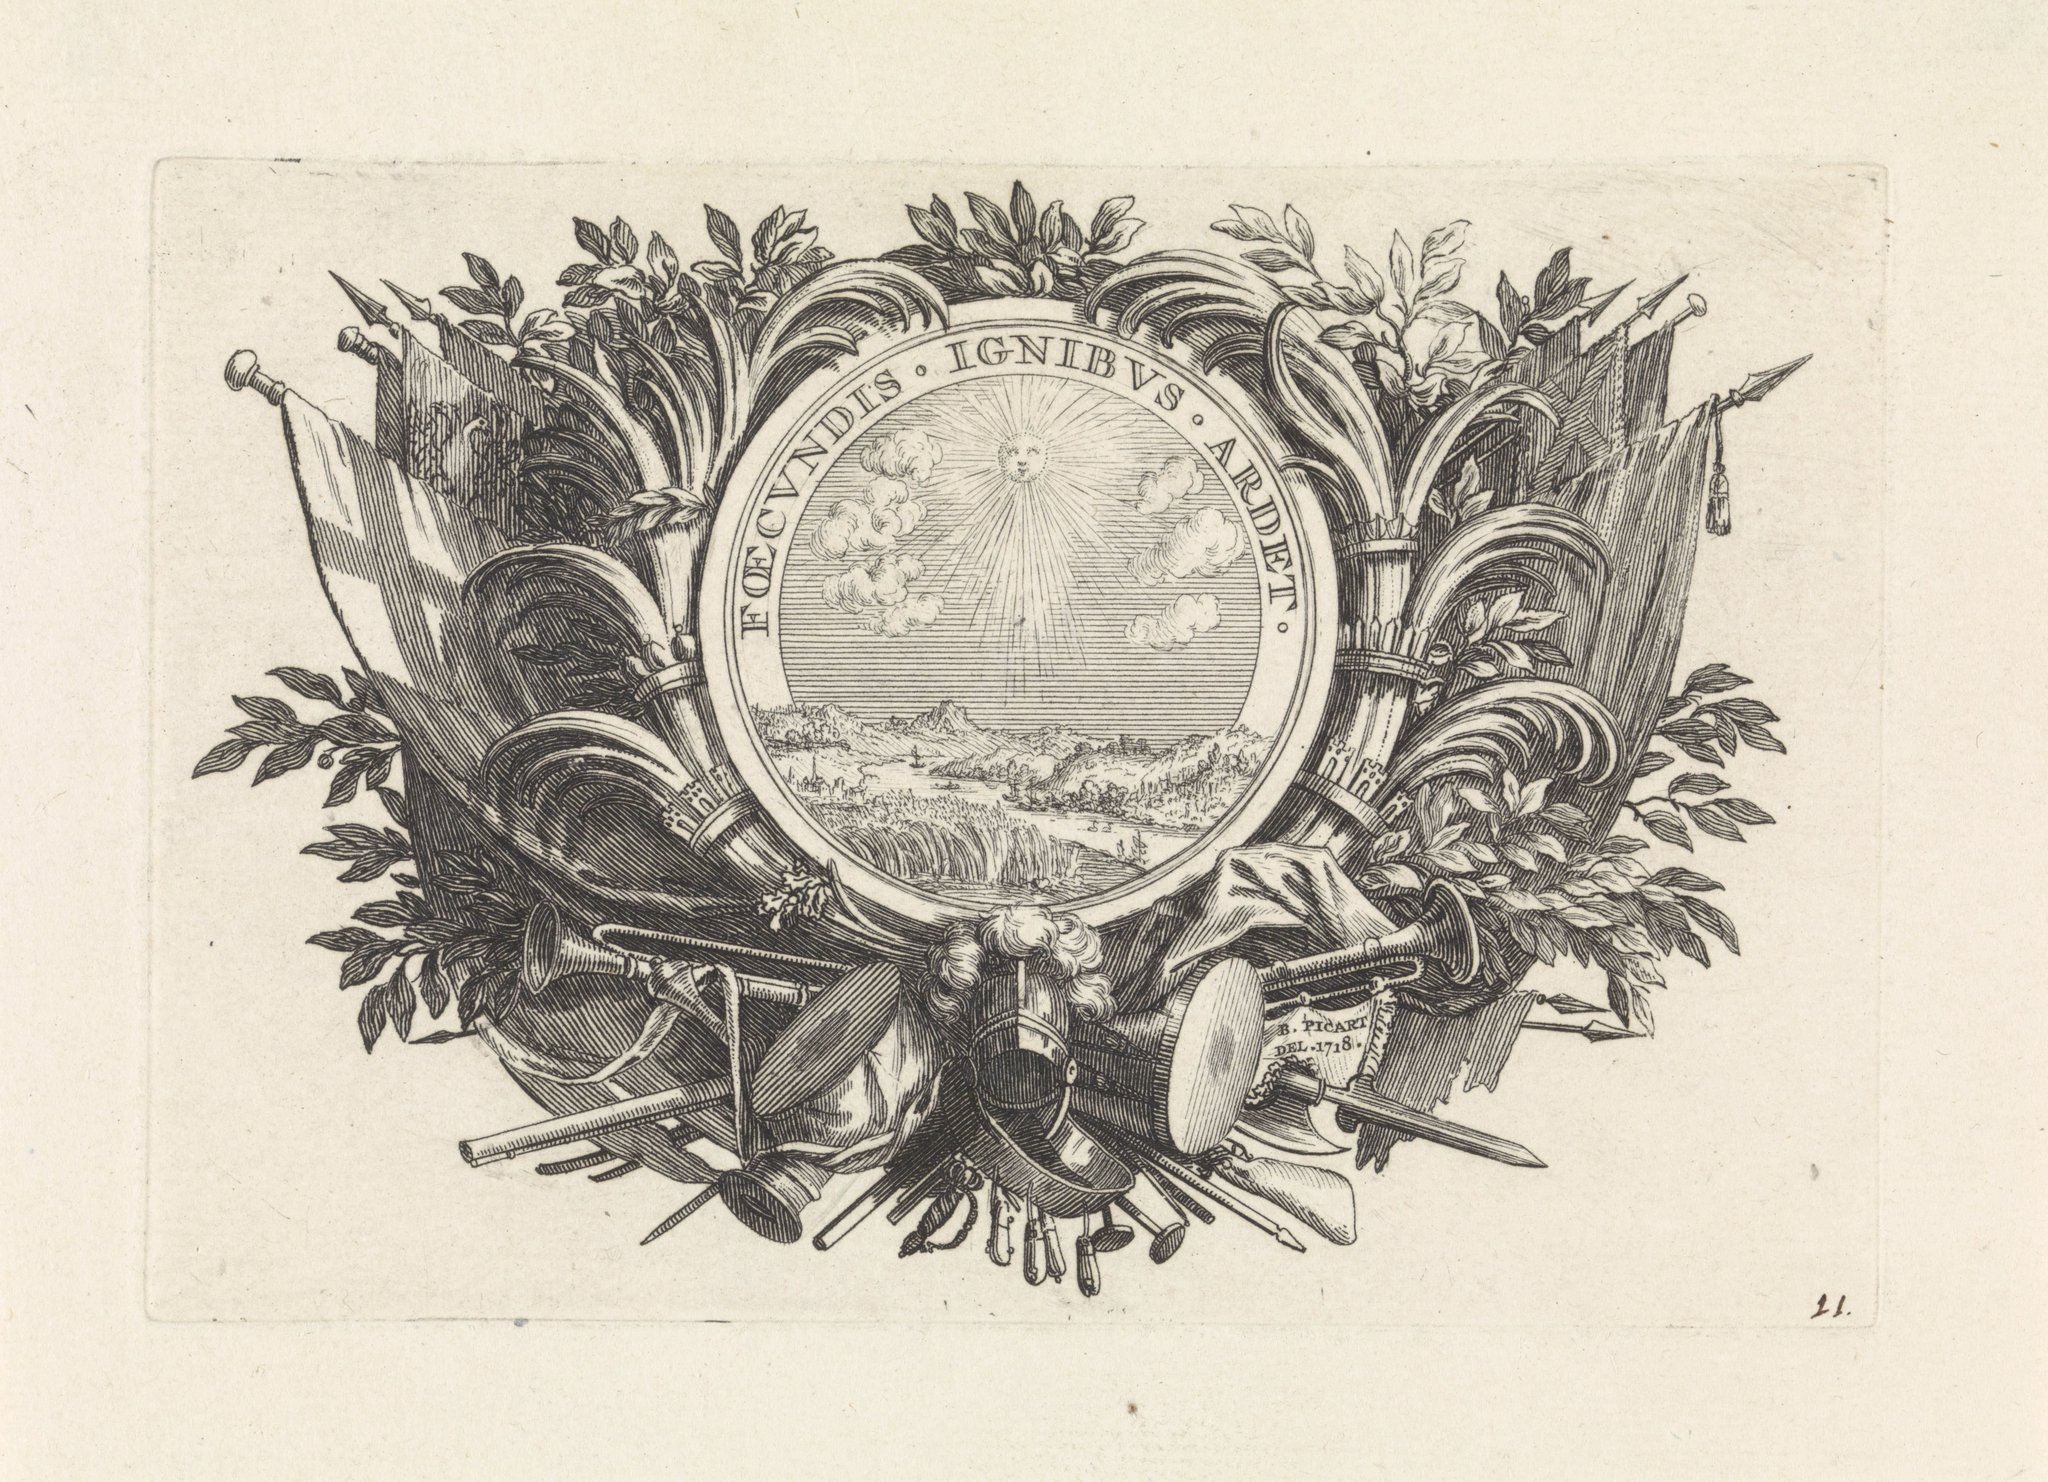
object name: print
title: Penning met een landschap waarover de zon haar stralen uitstort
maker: bernard picart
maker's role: draughtsman, print maker, publisher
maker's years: 1673-1733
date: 1718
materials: paper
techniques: engraving, etching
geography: amsterdam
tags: lodewijk xiv (koning van frankrijk), ornaments ~ art, landscapes, sun as celestial body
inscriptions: number: ‘11.’, collector's mark: Lugt 2233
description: Penning met de voorstelling van de zon, die schijnt over een landschap, waarop het koren groeit. Met het devies: Foecundis Ignibus Ardet. De voorstelling symboliseert de rol van Lodewijk XIV, koning van Frankrijk, als beschermer van de kunsten. Rondom banieren en wapenornamenten.